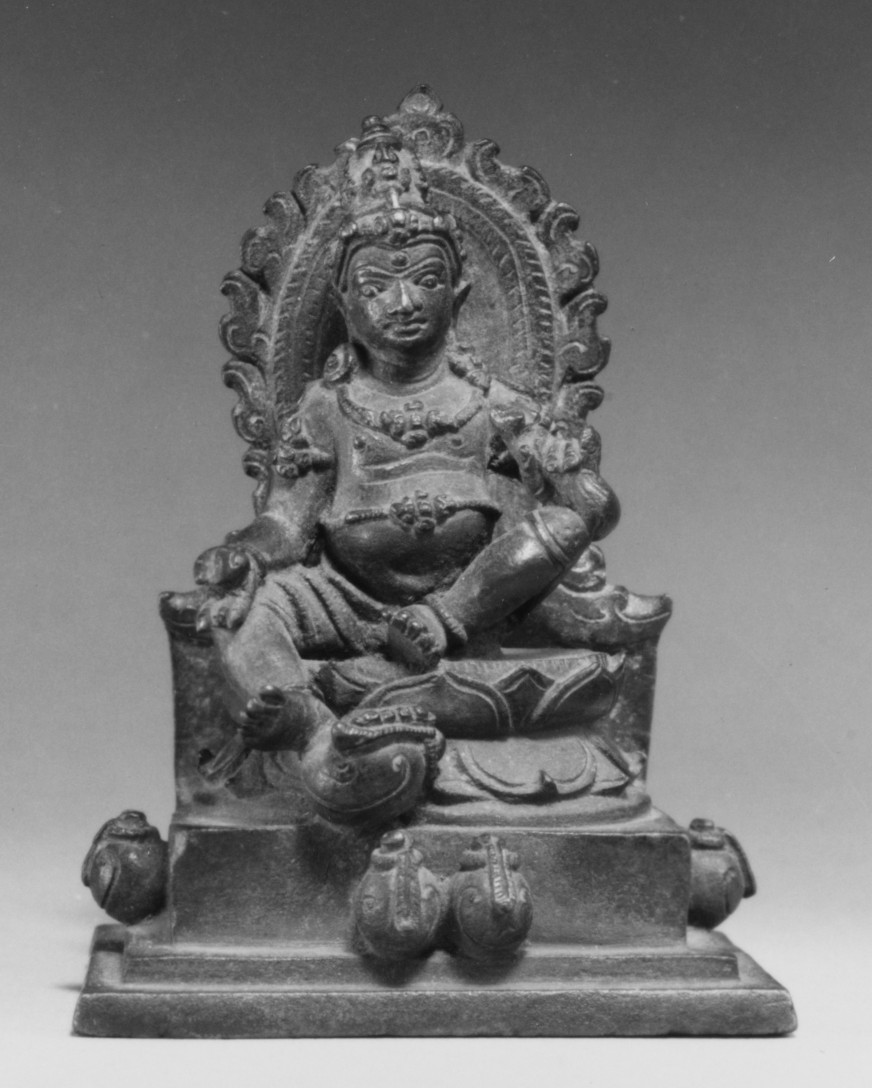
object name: figure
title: Seated Two-Armed Jambhala, the Buddhist God of Wealth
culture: indonesian, javanese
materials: bronze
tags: buddhism,deities